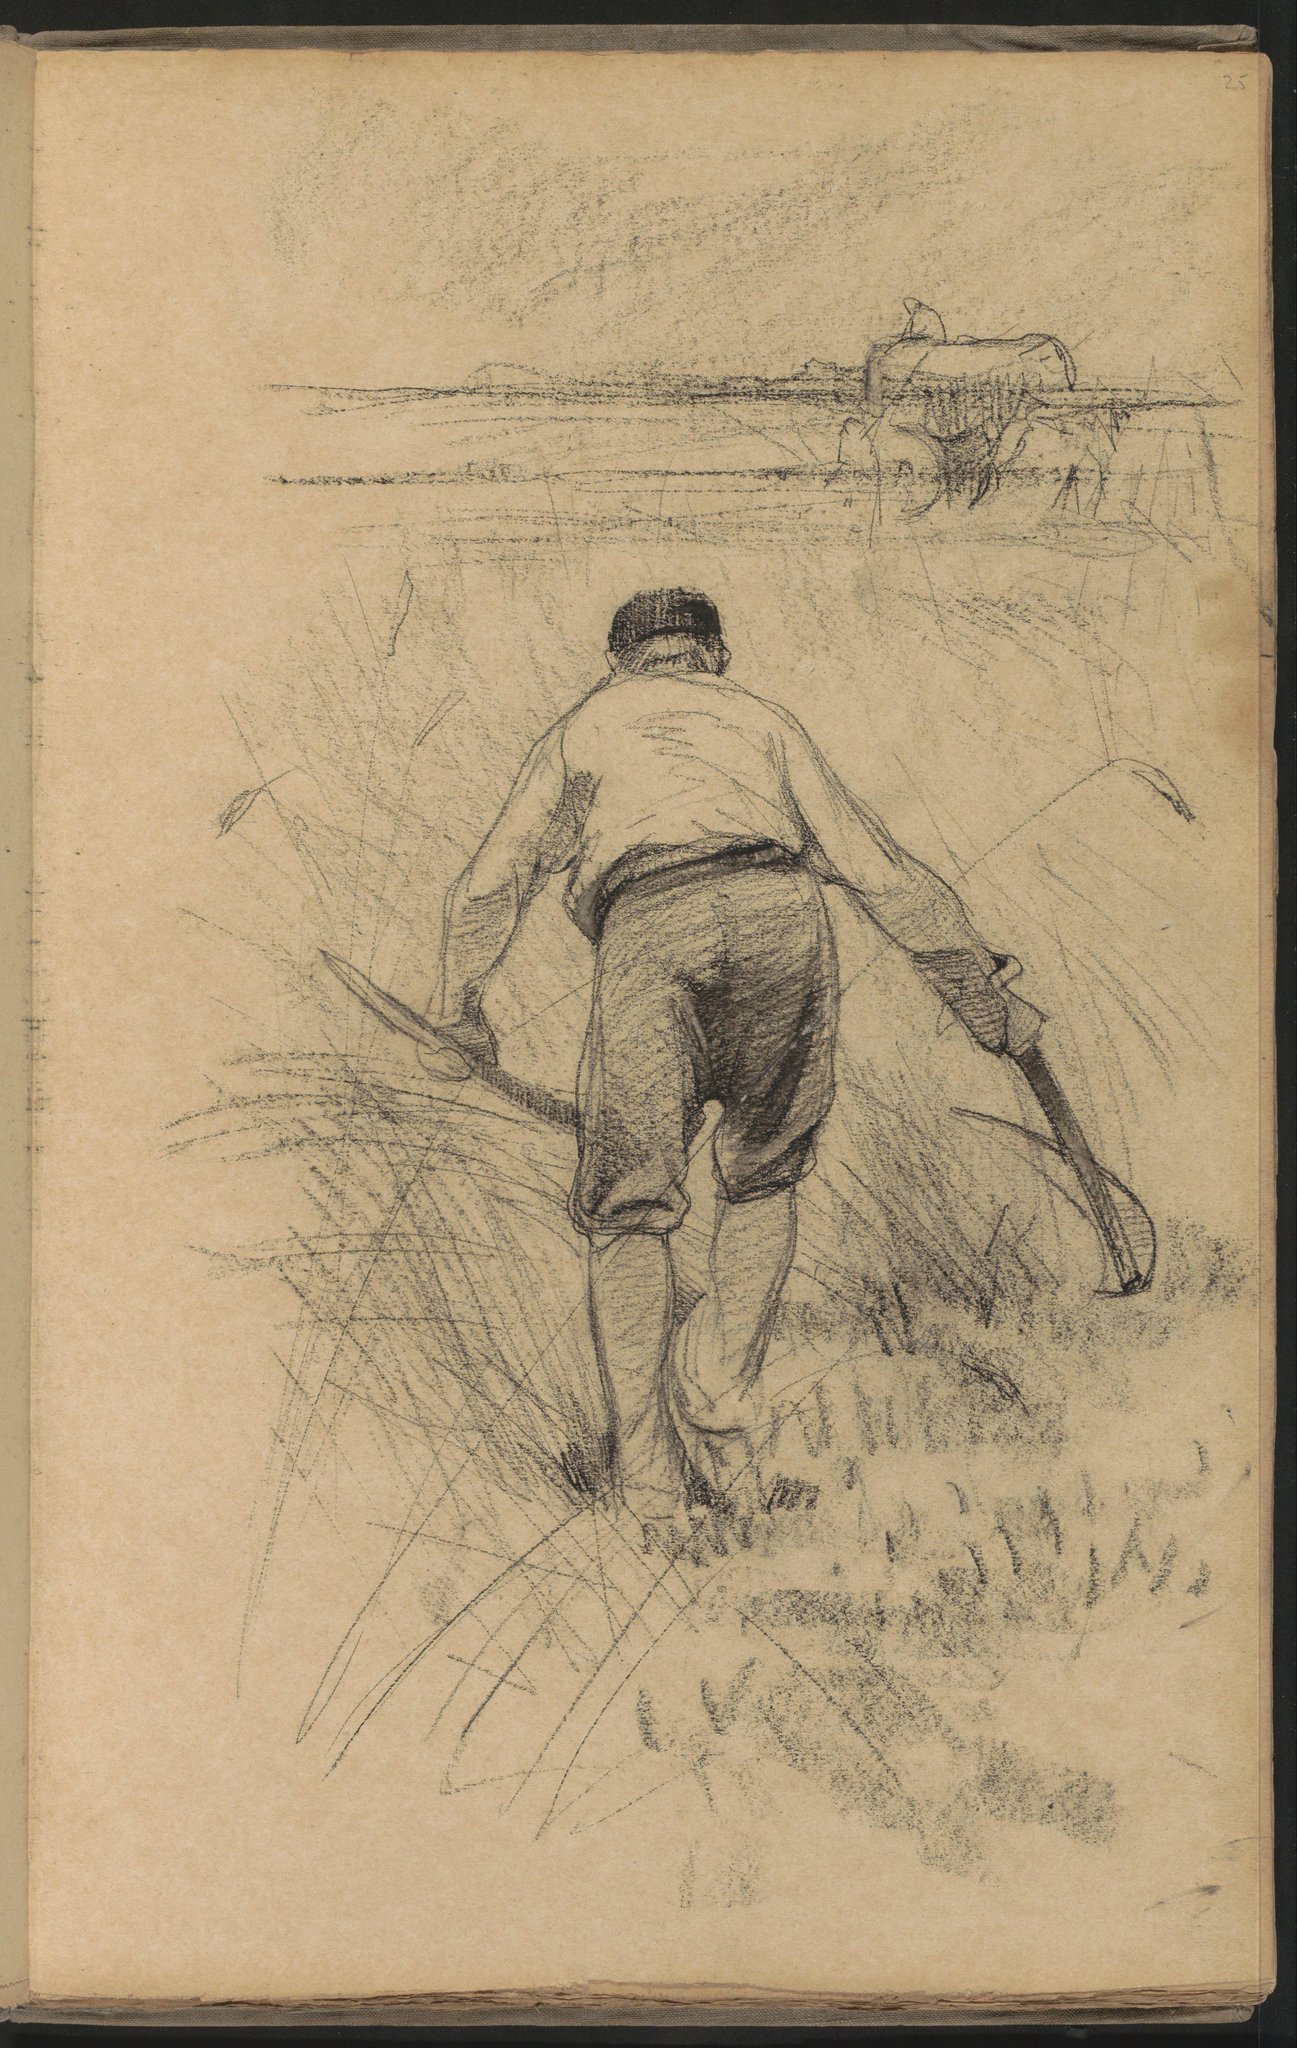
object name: sketchbook leaf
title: Hooiende boer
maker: willem witsen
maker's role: draughtsman, painter, print maker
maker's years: 1860-1923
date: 1884-1887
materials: chalk, paper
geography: ewijkshoeve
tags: agricultural implements: scythe, farmers, hay-wagon, reaping, picking, mowing ~ harvest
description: Op de achtergrond een paardenkar met hooi. Pagina 25 uit een schetsboek met 42 bladen vervaardigd rond de Ewijkshoeve.